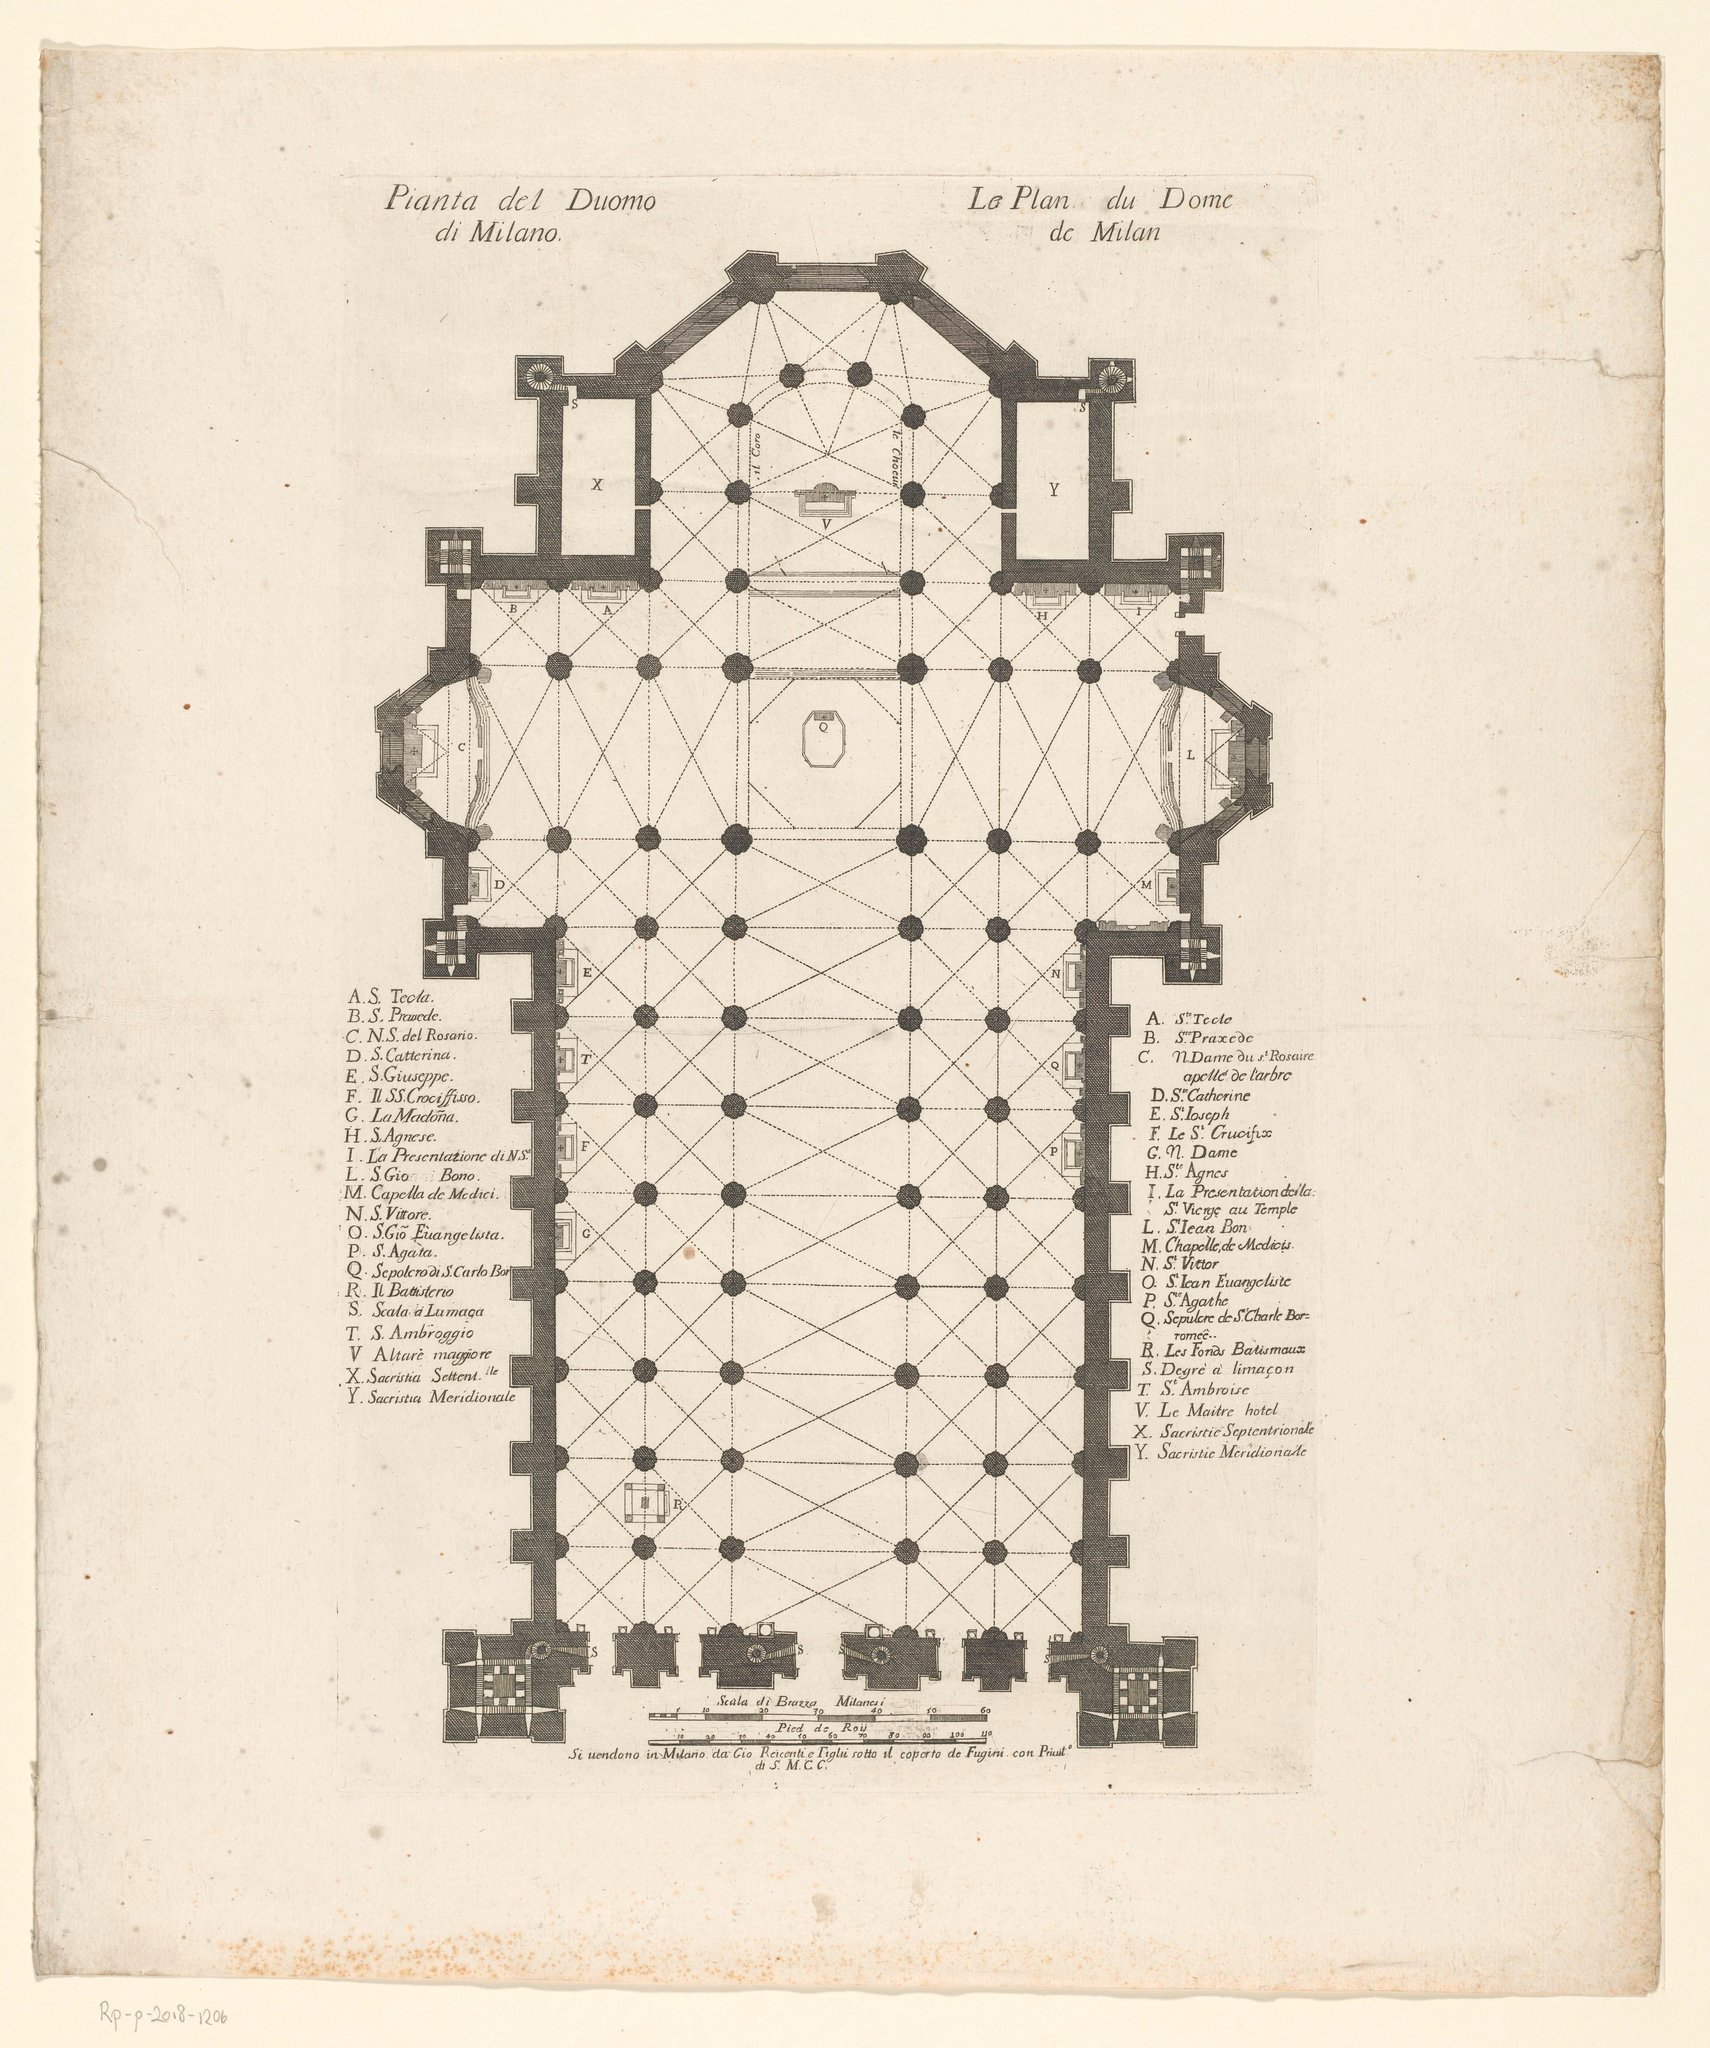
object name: area plan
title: Pianta del Duomo di Milano / Le plan du Dome de Milan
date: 1728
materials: paper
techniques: engraving, etching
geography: milan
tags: interior of church, plan ~ architecture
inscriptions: collector's mark: Lugt 2228